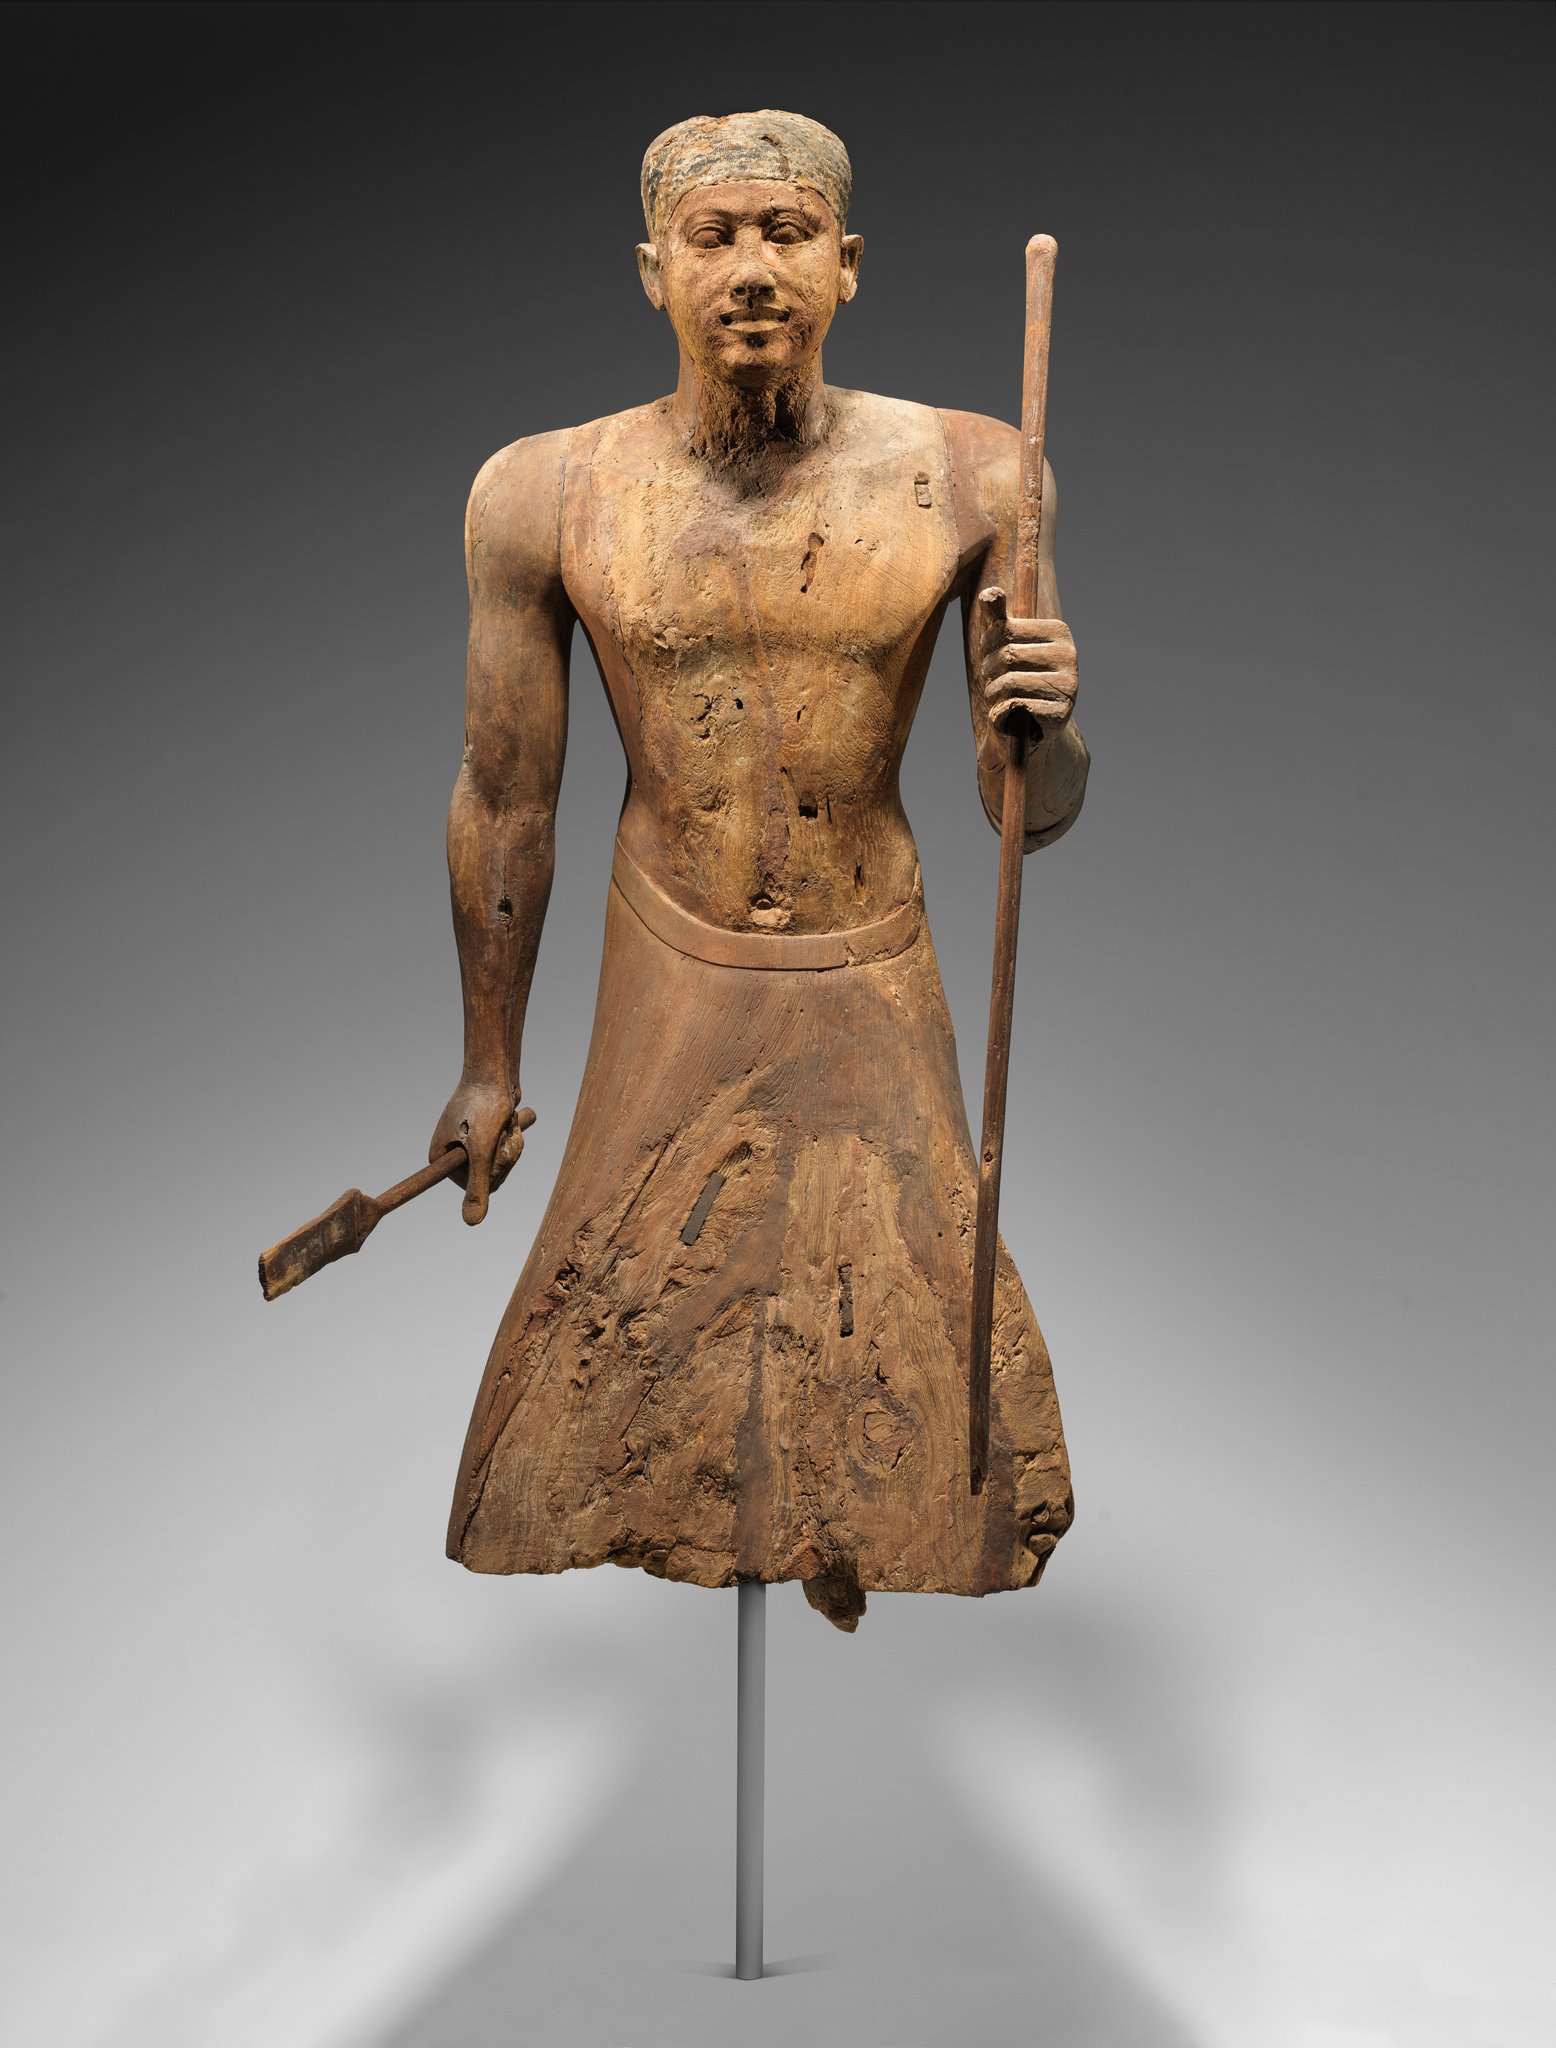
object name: statue, merti, cropped hair, mitry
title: The Statue of the Official Mitry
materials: gesso, paint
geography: egypt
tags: men